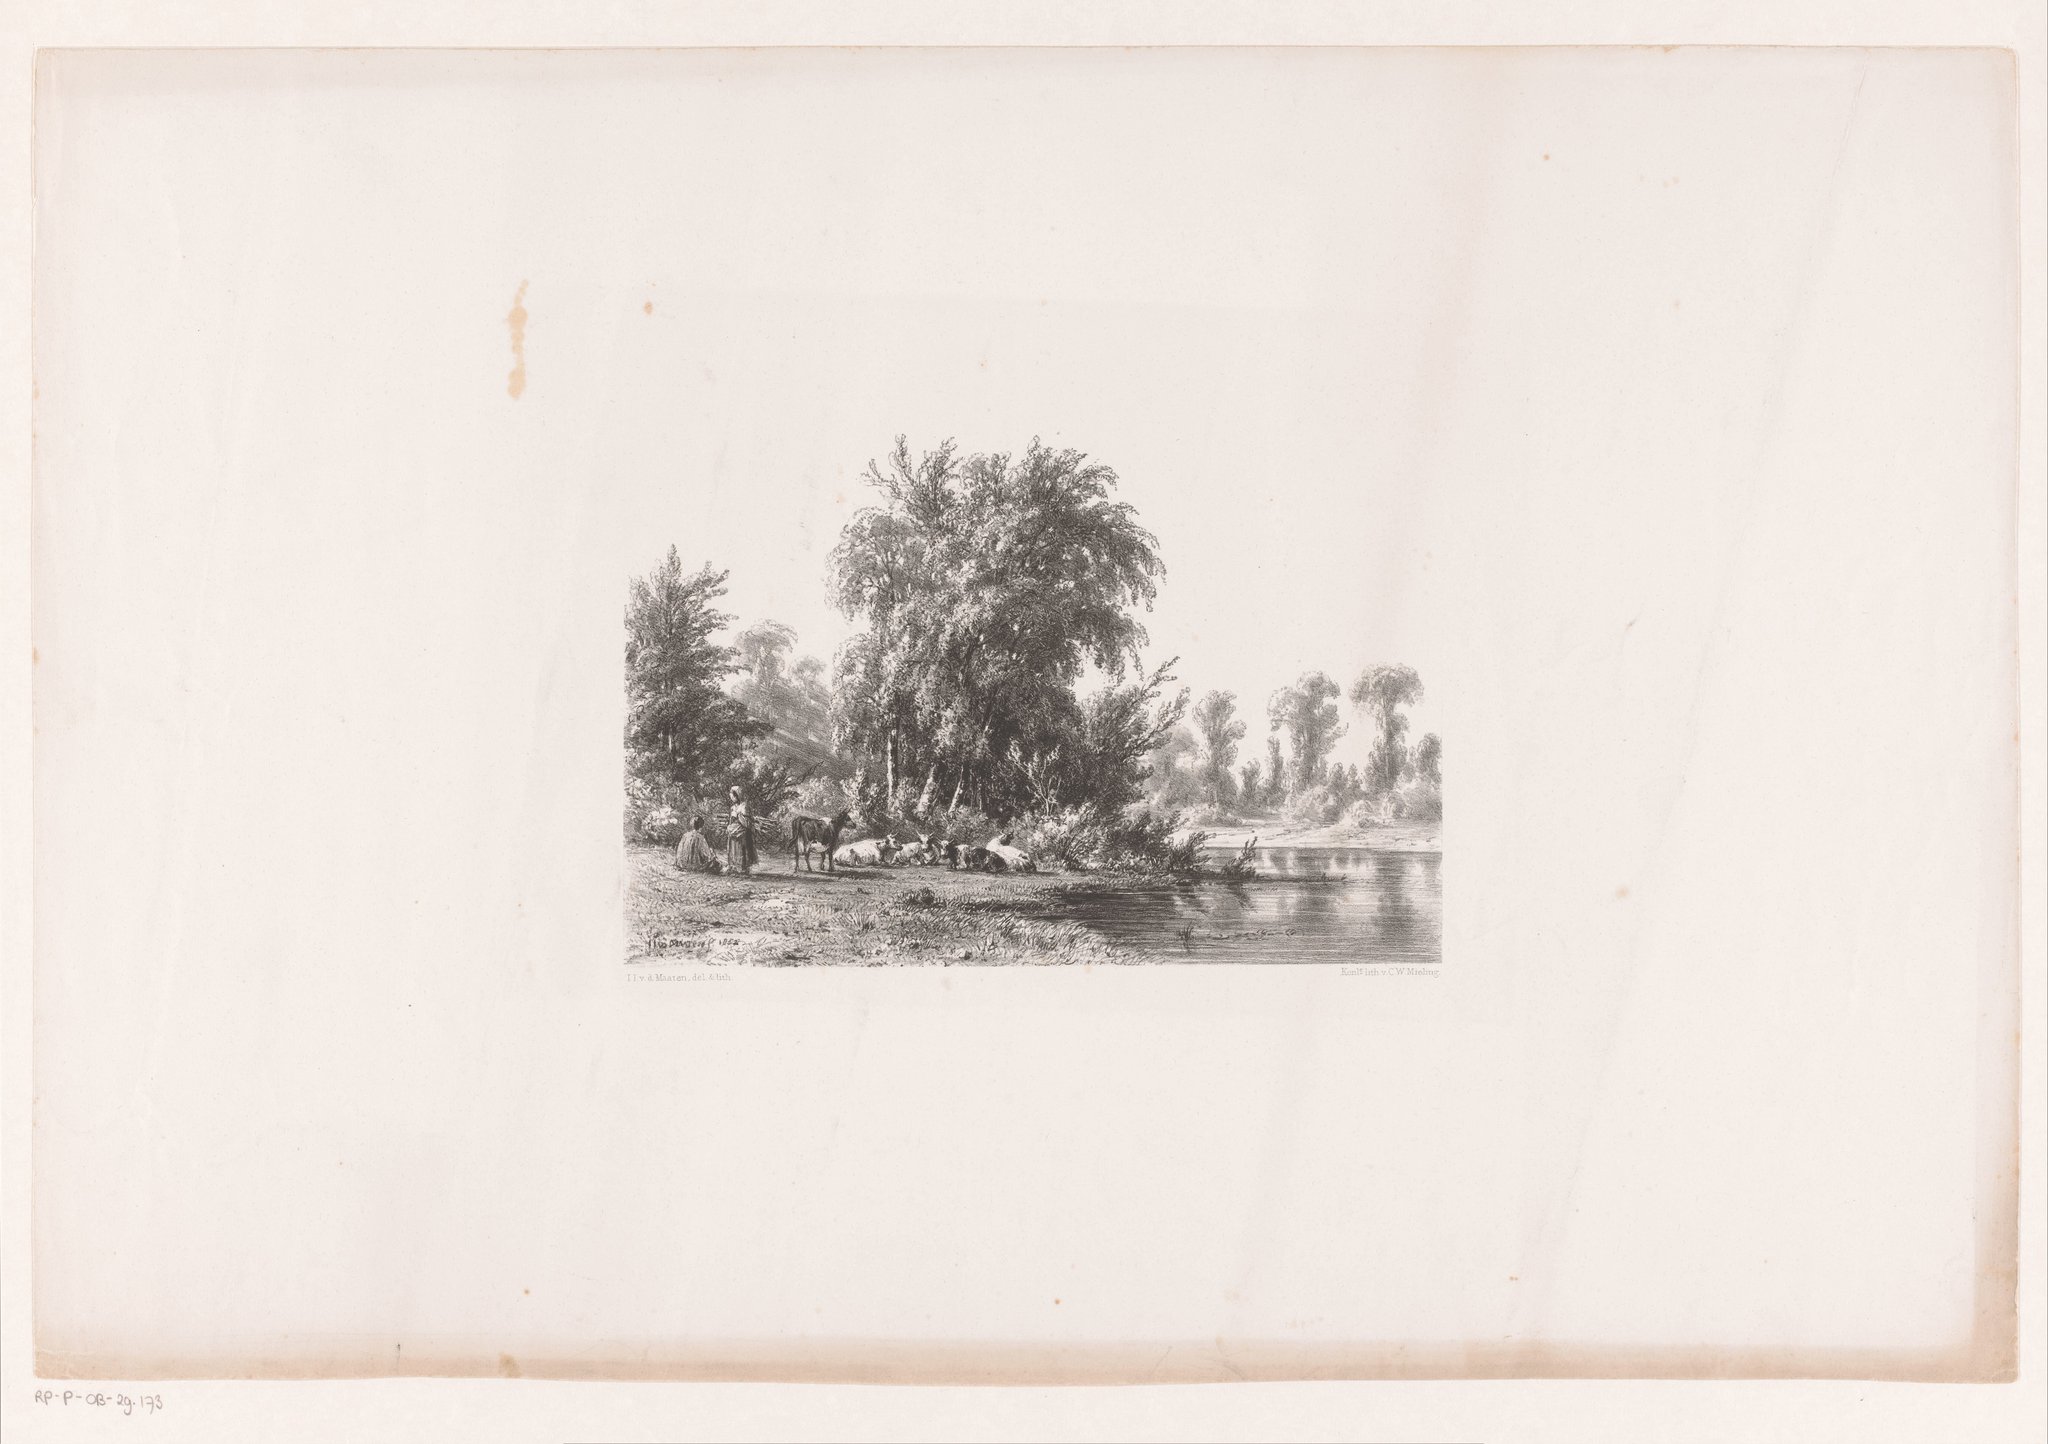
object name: print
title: Rustende kudde bij het water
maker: jacob jan van der maaten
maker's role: draughtsman, print maker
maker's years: 1820-1879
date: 1852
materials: paper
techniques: lithograph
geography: the hague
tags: woodgathering, woodgatherer, bovine cattle, river (+ landscape with figures, staffage), herd, flock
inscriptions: collector's mark: Lugt 2228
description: Links bij de kudde een man en een vrouw. De vrouw heeft een bos hout bij zich.